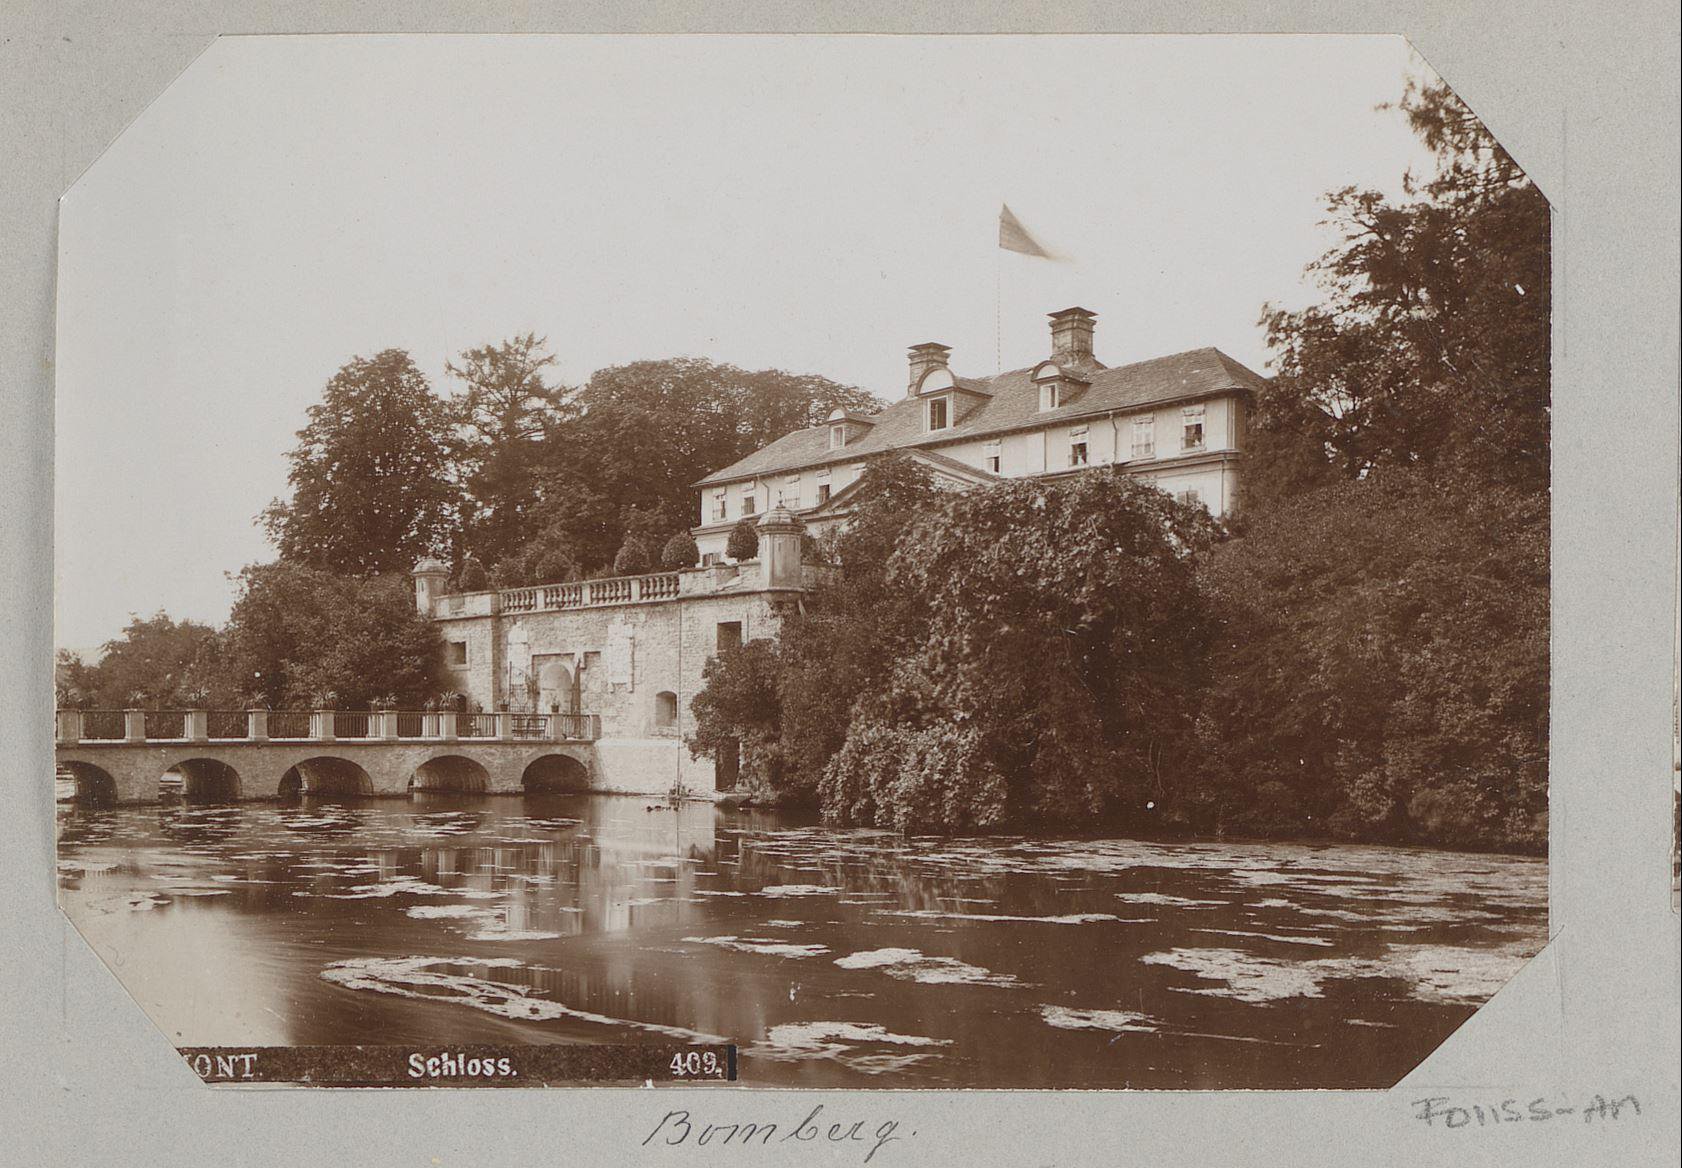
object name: album leaf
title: Gezicht op Schloss Pyrmont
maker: Anonymous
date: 1890-1897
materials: photographic support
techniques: collodion silver print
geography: bad pyrmont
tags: castle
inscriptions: annotation: ‘Pyrmont/ Schloss’, inscription: ‘Pyrmont Schloss. 409’